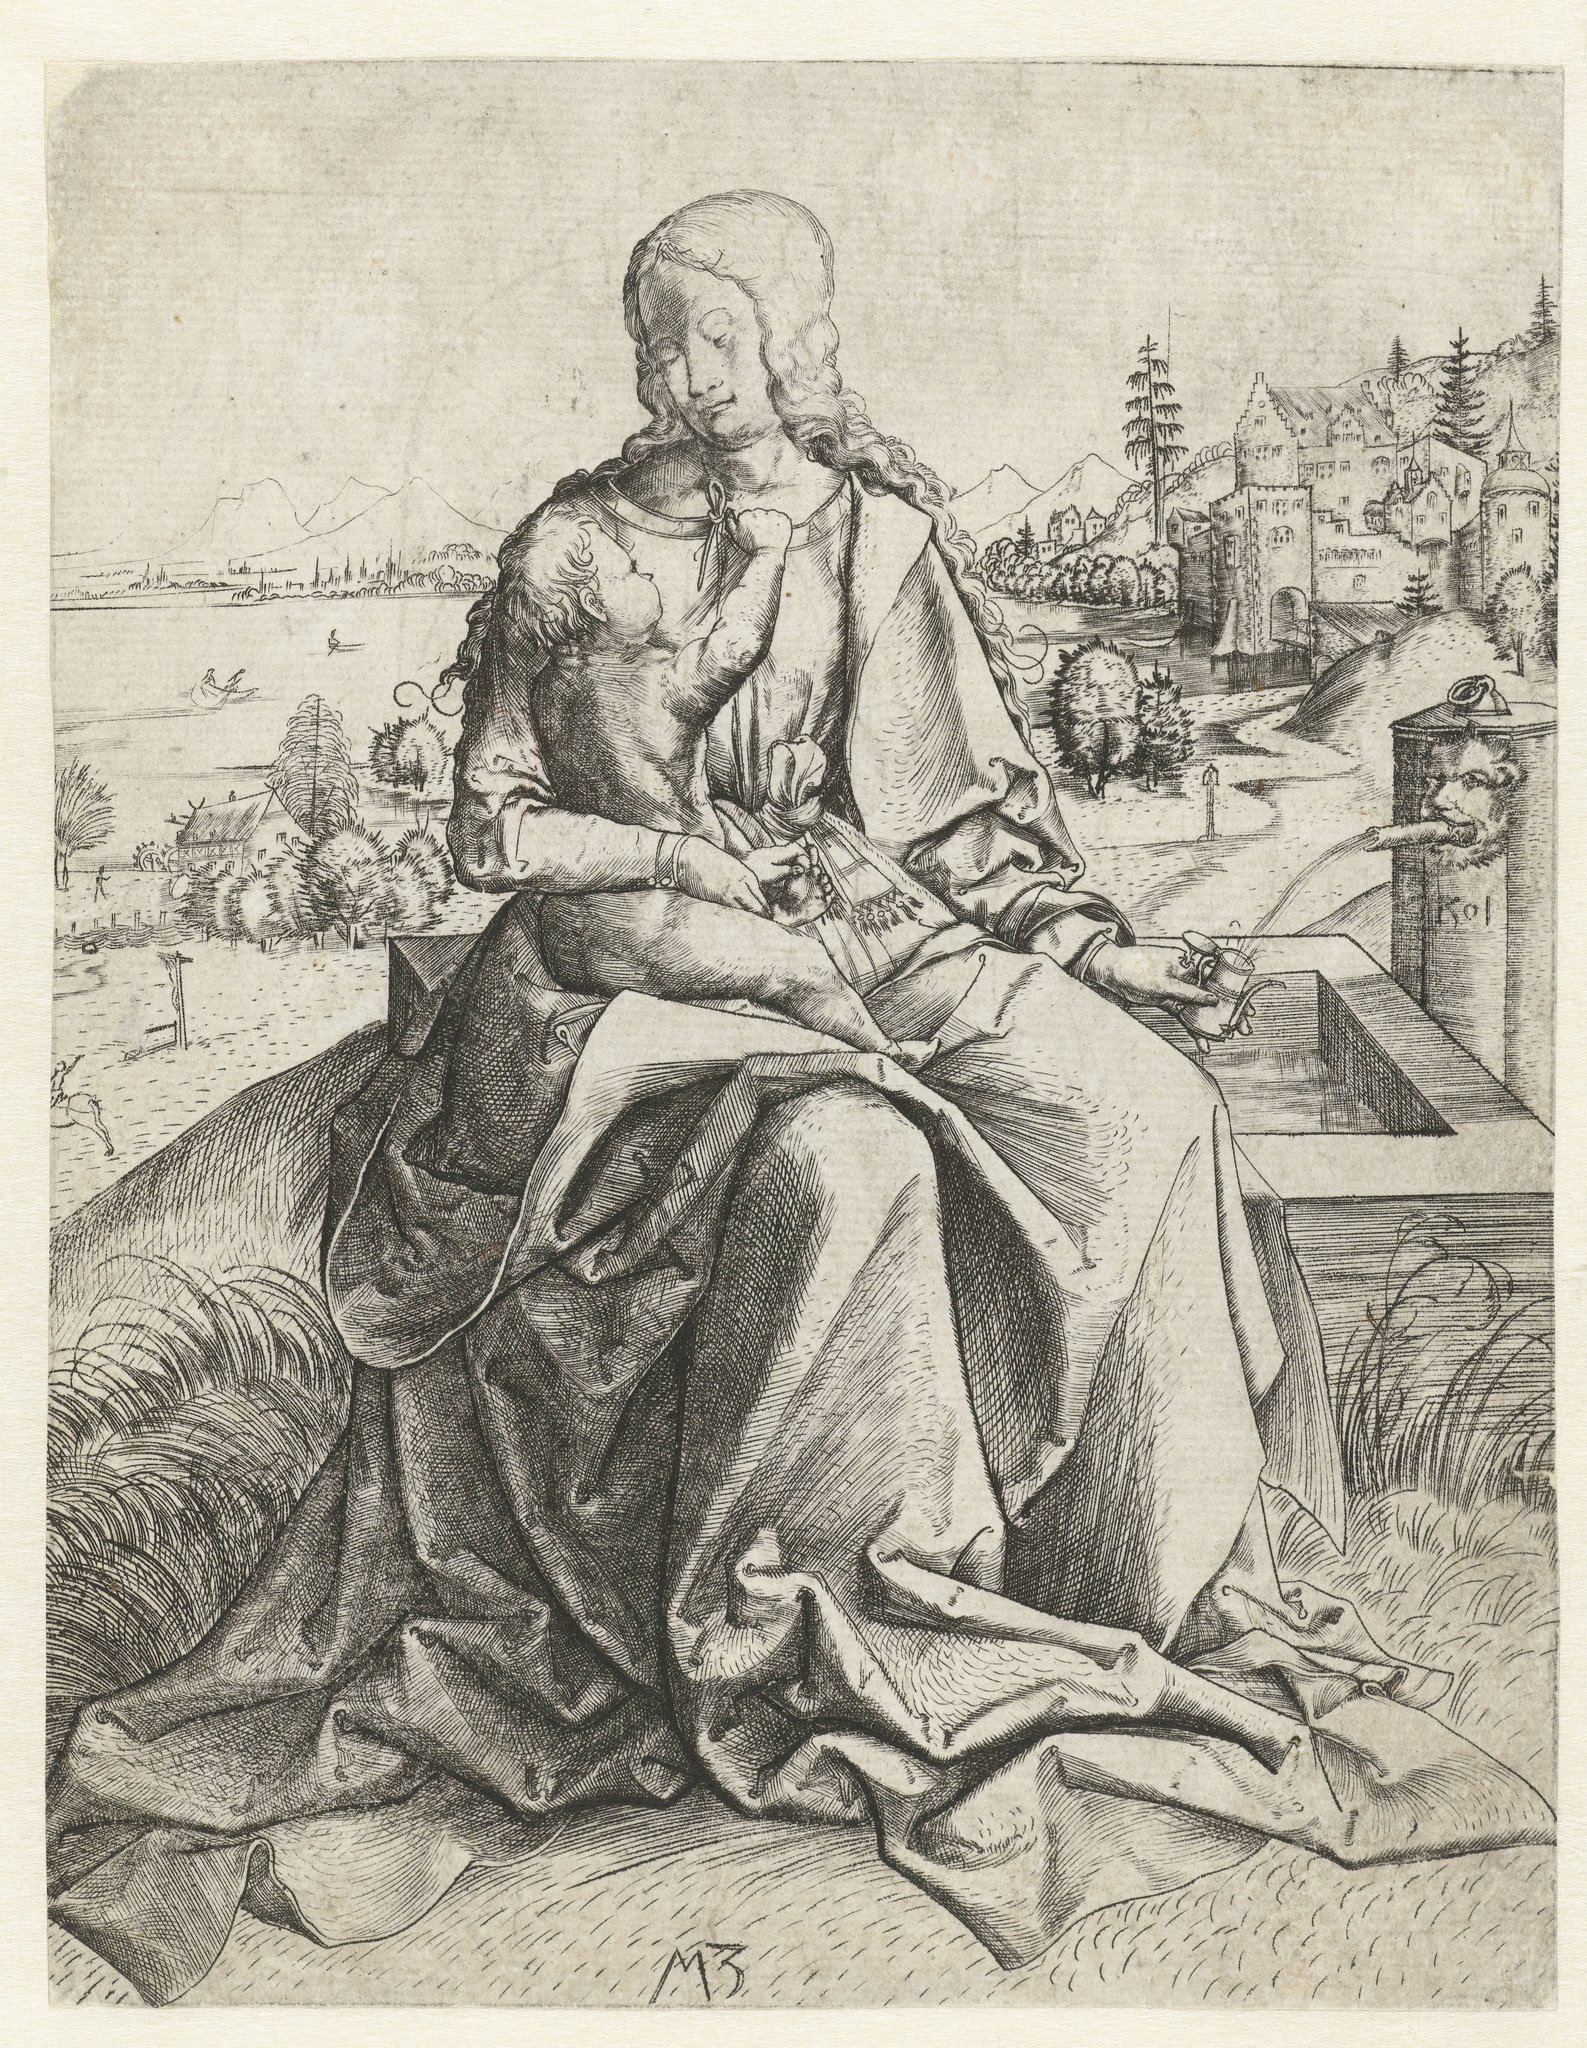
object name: print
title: Madonna bij een bron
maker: monogrammist mz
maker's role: print maker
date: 1501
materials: paper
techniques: engraving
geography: germany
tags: madonna: mary sitting or enthroned, the christ-child in her lap (or in front of her bosom) (mary sometimes represented half-length), utilitarian, public pump or water fountain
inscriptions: collector's mark: Lugt 212, collector's mark: Lugt 2228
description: Maria zit met het Christuskind op schoot op de rand van een bron. Ze vangt water uit de kraan op in een kannetje. Op de achtergrond een burcht aan een baai.